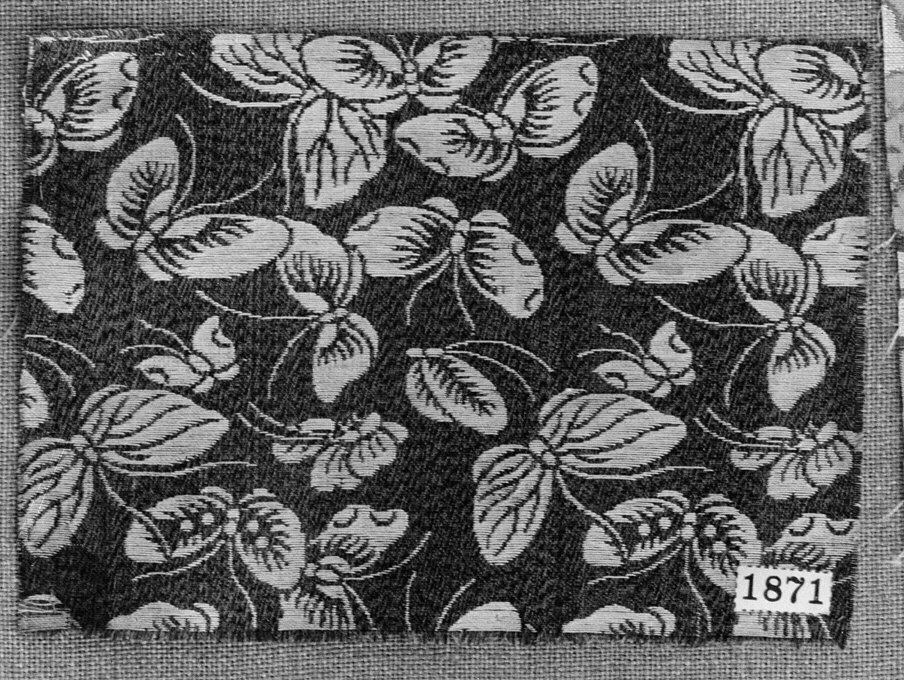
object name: piece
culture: japanese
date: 1615-1868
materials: silk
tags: butterflies